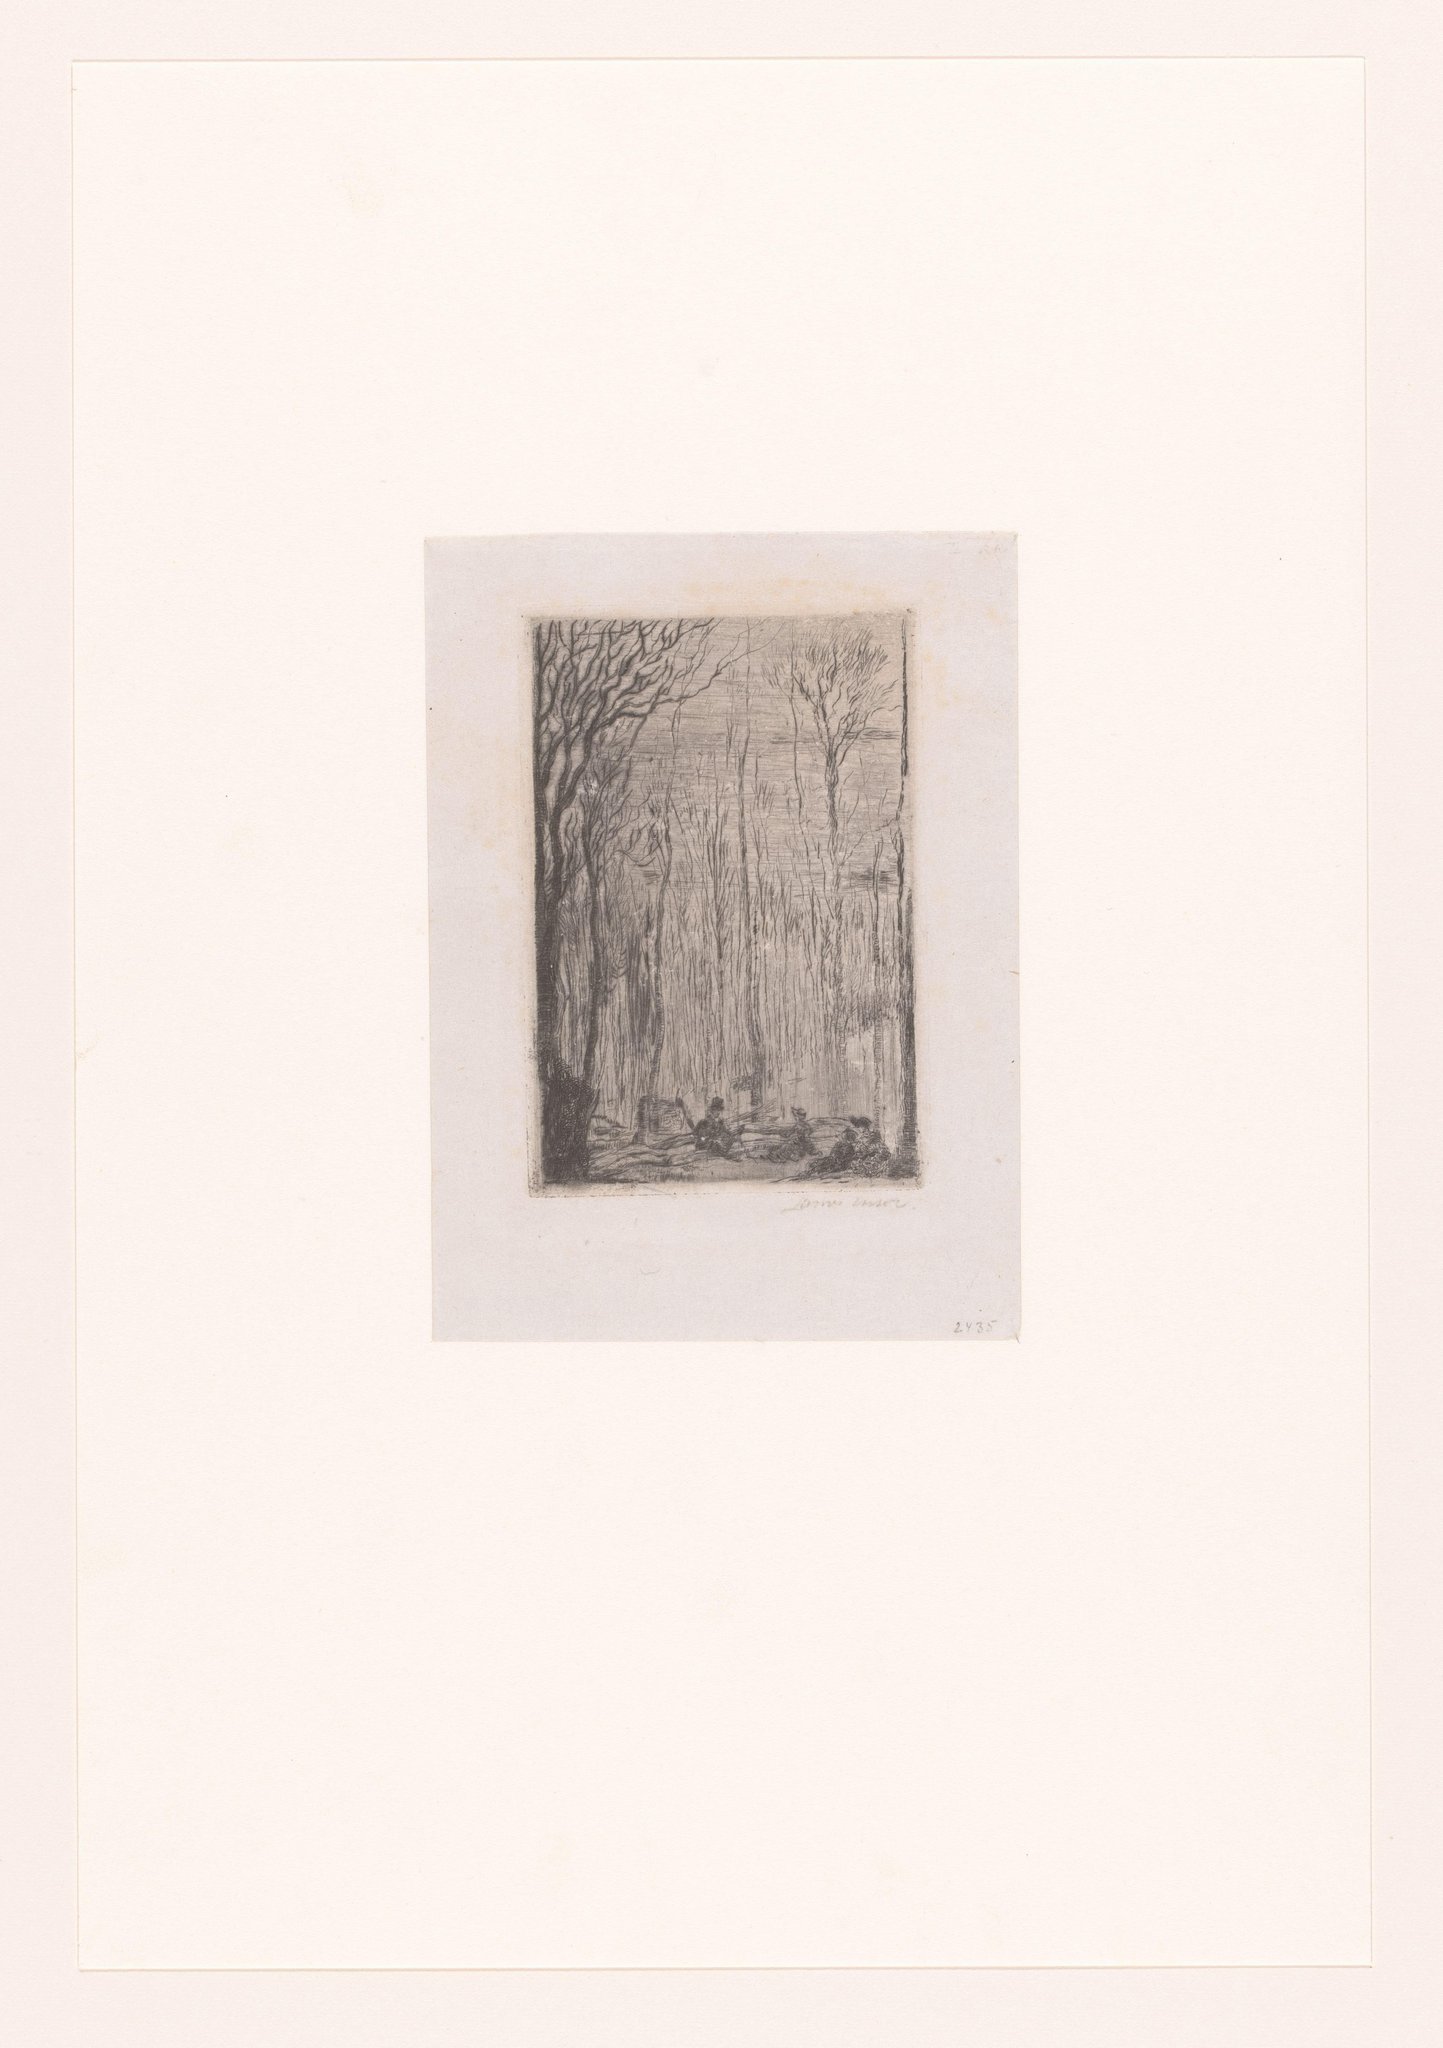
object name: print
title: Figuren in het bos bij Groenendael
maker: james ensor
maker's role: print maker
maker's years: 1860-1949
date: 1888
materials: paper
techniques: drypoint, etching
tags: forest, wood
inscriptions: collector's mark: Lugt 2228, collector's mark: Lugt 4731